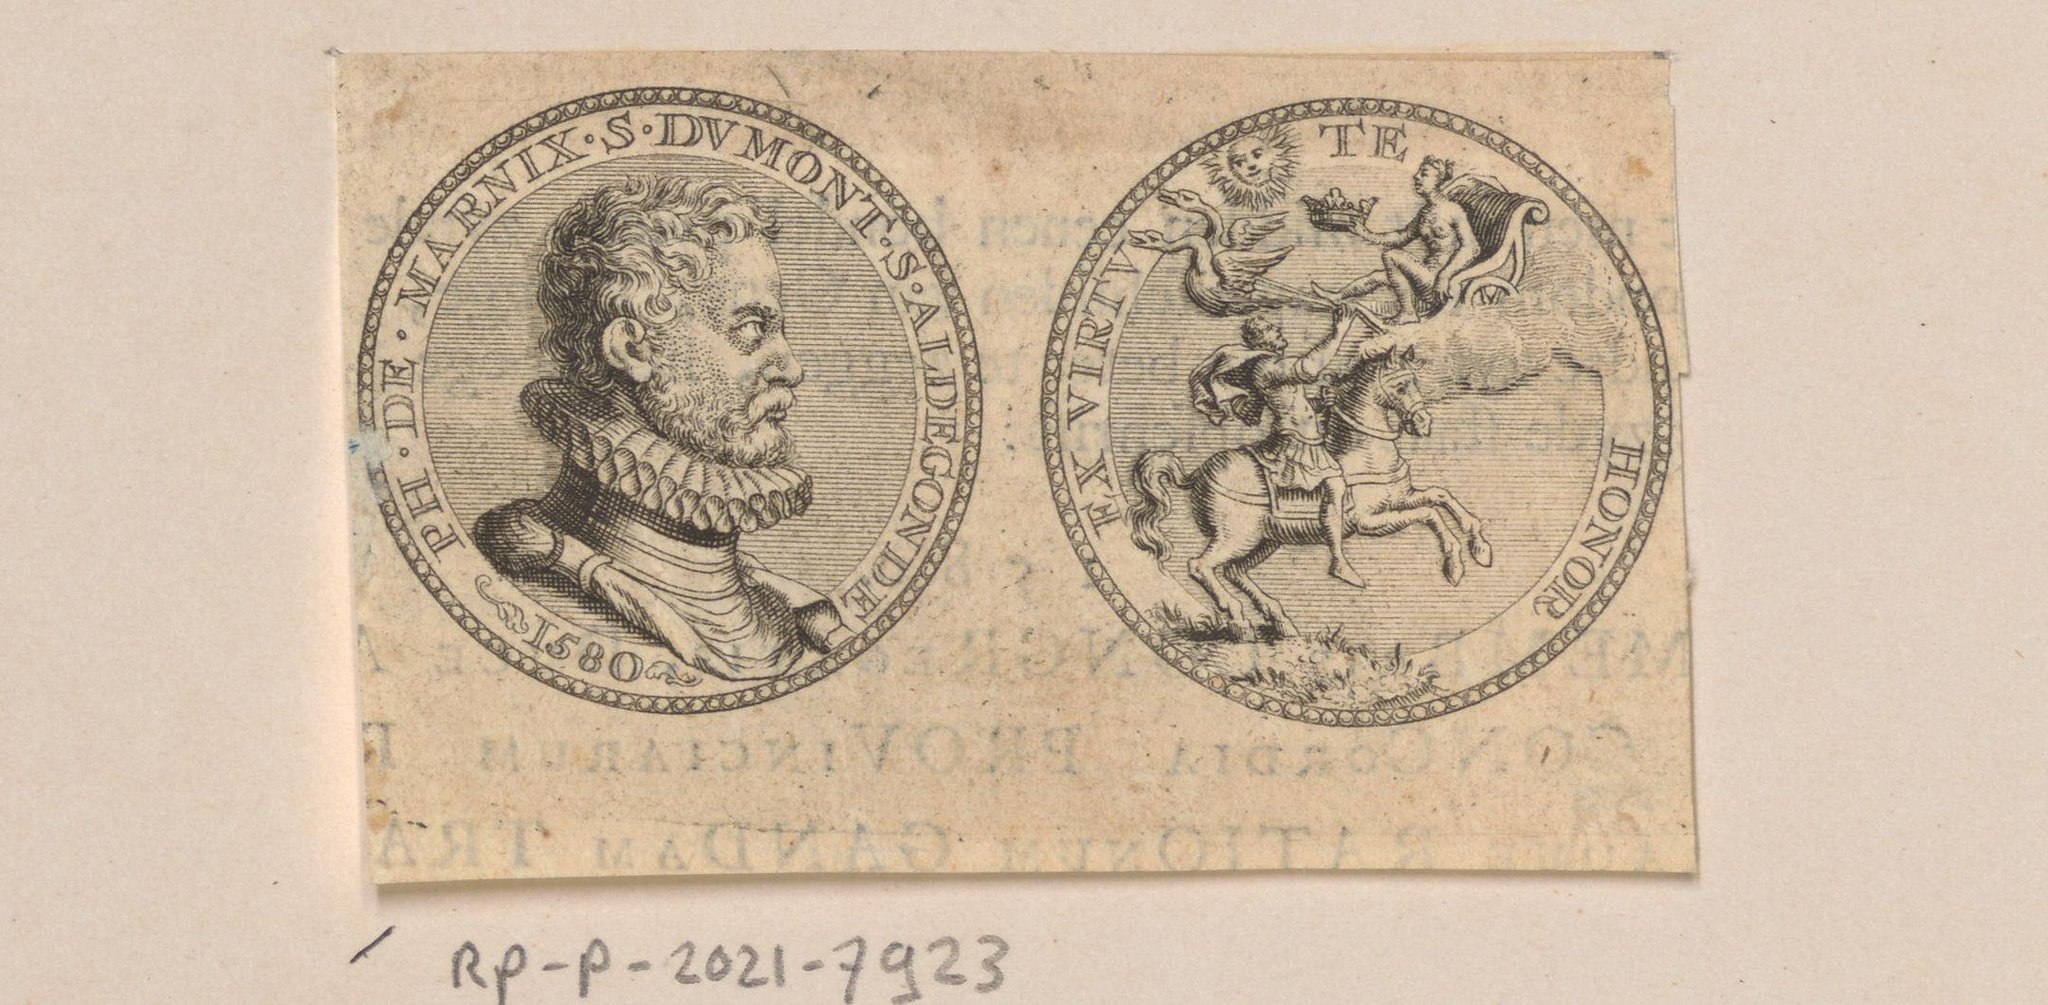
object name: print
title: Voor- en achterzijde van een penning met het portret van Filips van Marnix, heer van Sint-Aldegonde en allegorie met Venus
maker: Anonymous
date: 1723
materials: paper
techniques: etching, letterpress printing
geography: northern netherlands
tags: brussels, leiden, filips van marnix van sint-aldegonde, crown (symbol of sovereignty), historical persons, portrait of a writer, medal (considered as a piece of sculpture, regardless of its specific function), triumph of venus; 'carro di venere' (ripa)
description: Prent uit: Loon, Gerard van. Beschryving der Nederlandsche historipenningen (...). Den Haag: Christiaan van Lom et al., 1723, dl. 1, p. 285.